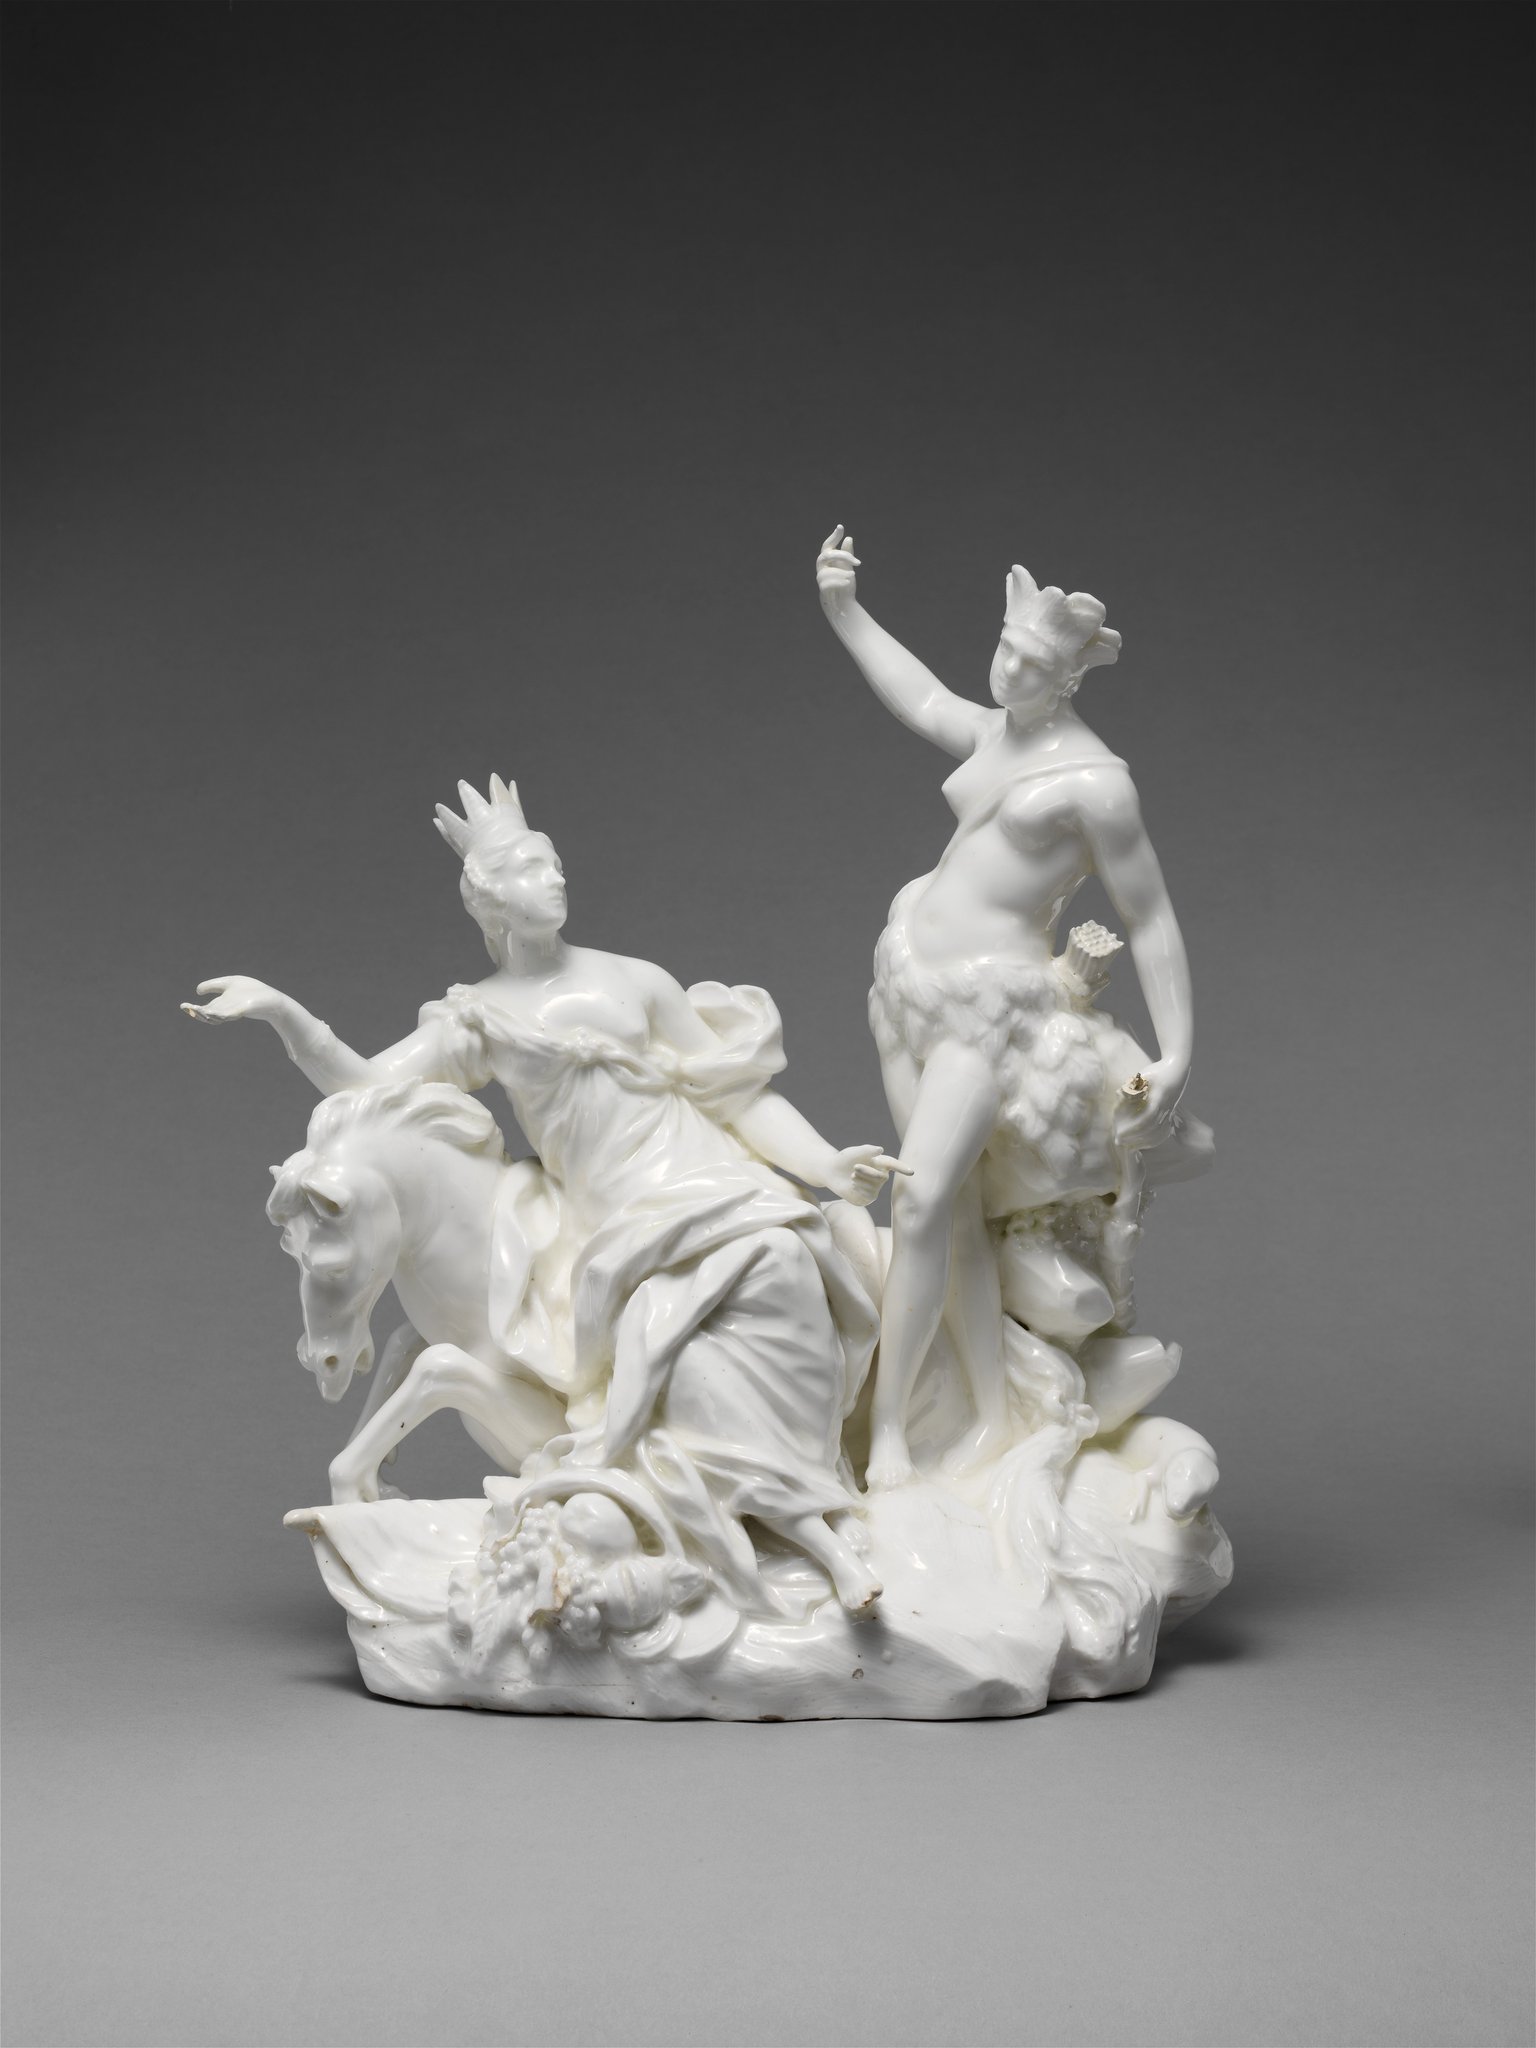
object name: group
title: Europe and America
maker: vincennes manufactory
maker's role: manufactory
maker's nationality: french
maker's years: 1740-1756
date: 1752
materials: soft paste porcelain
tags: men,women,horses